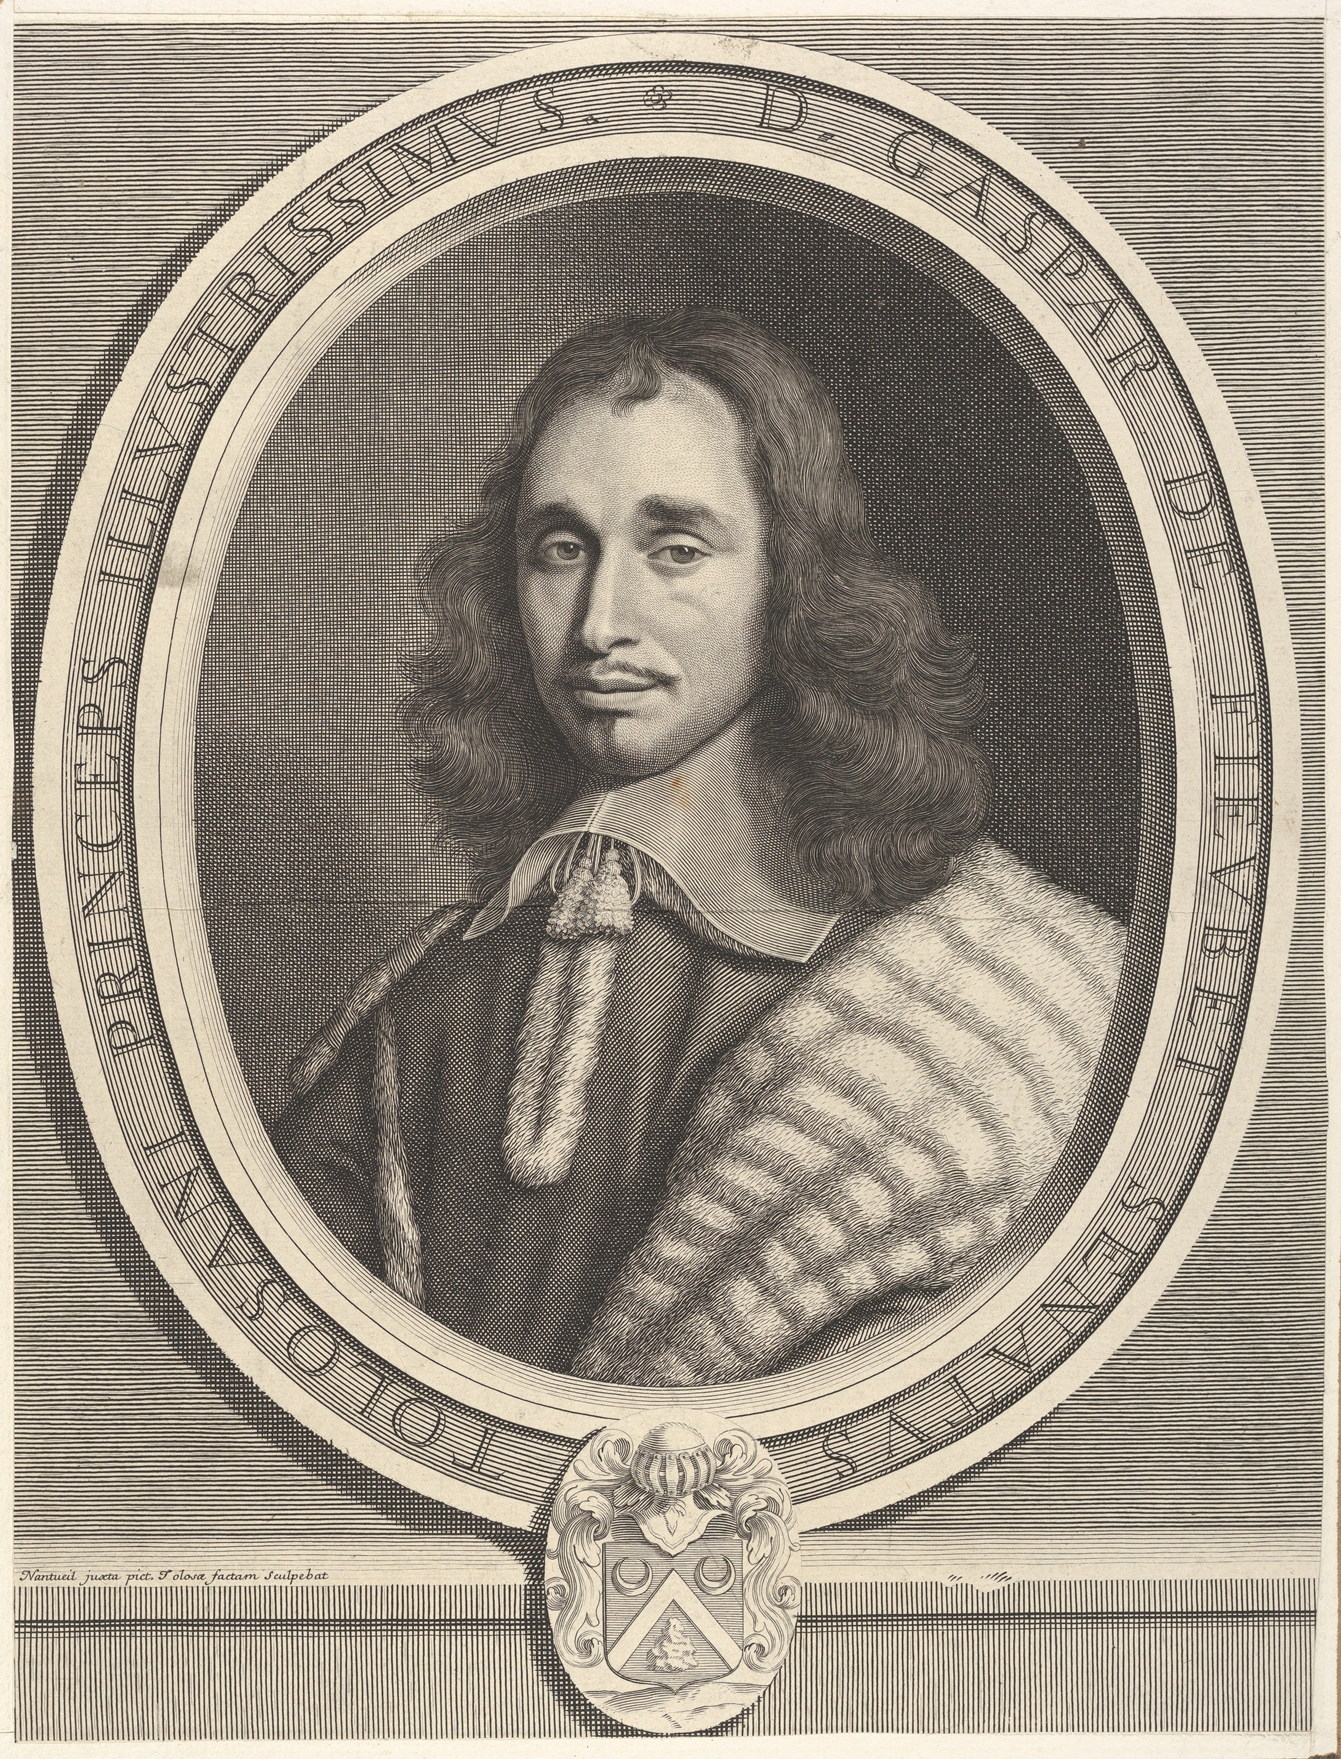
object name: print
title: Gaspard de Fieubet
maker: robert nanteuil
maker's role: artist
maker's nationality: french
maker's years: 1623-1678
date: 1654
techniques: engraving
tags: men,portraits,coat of arms